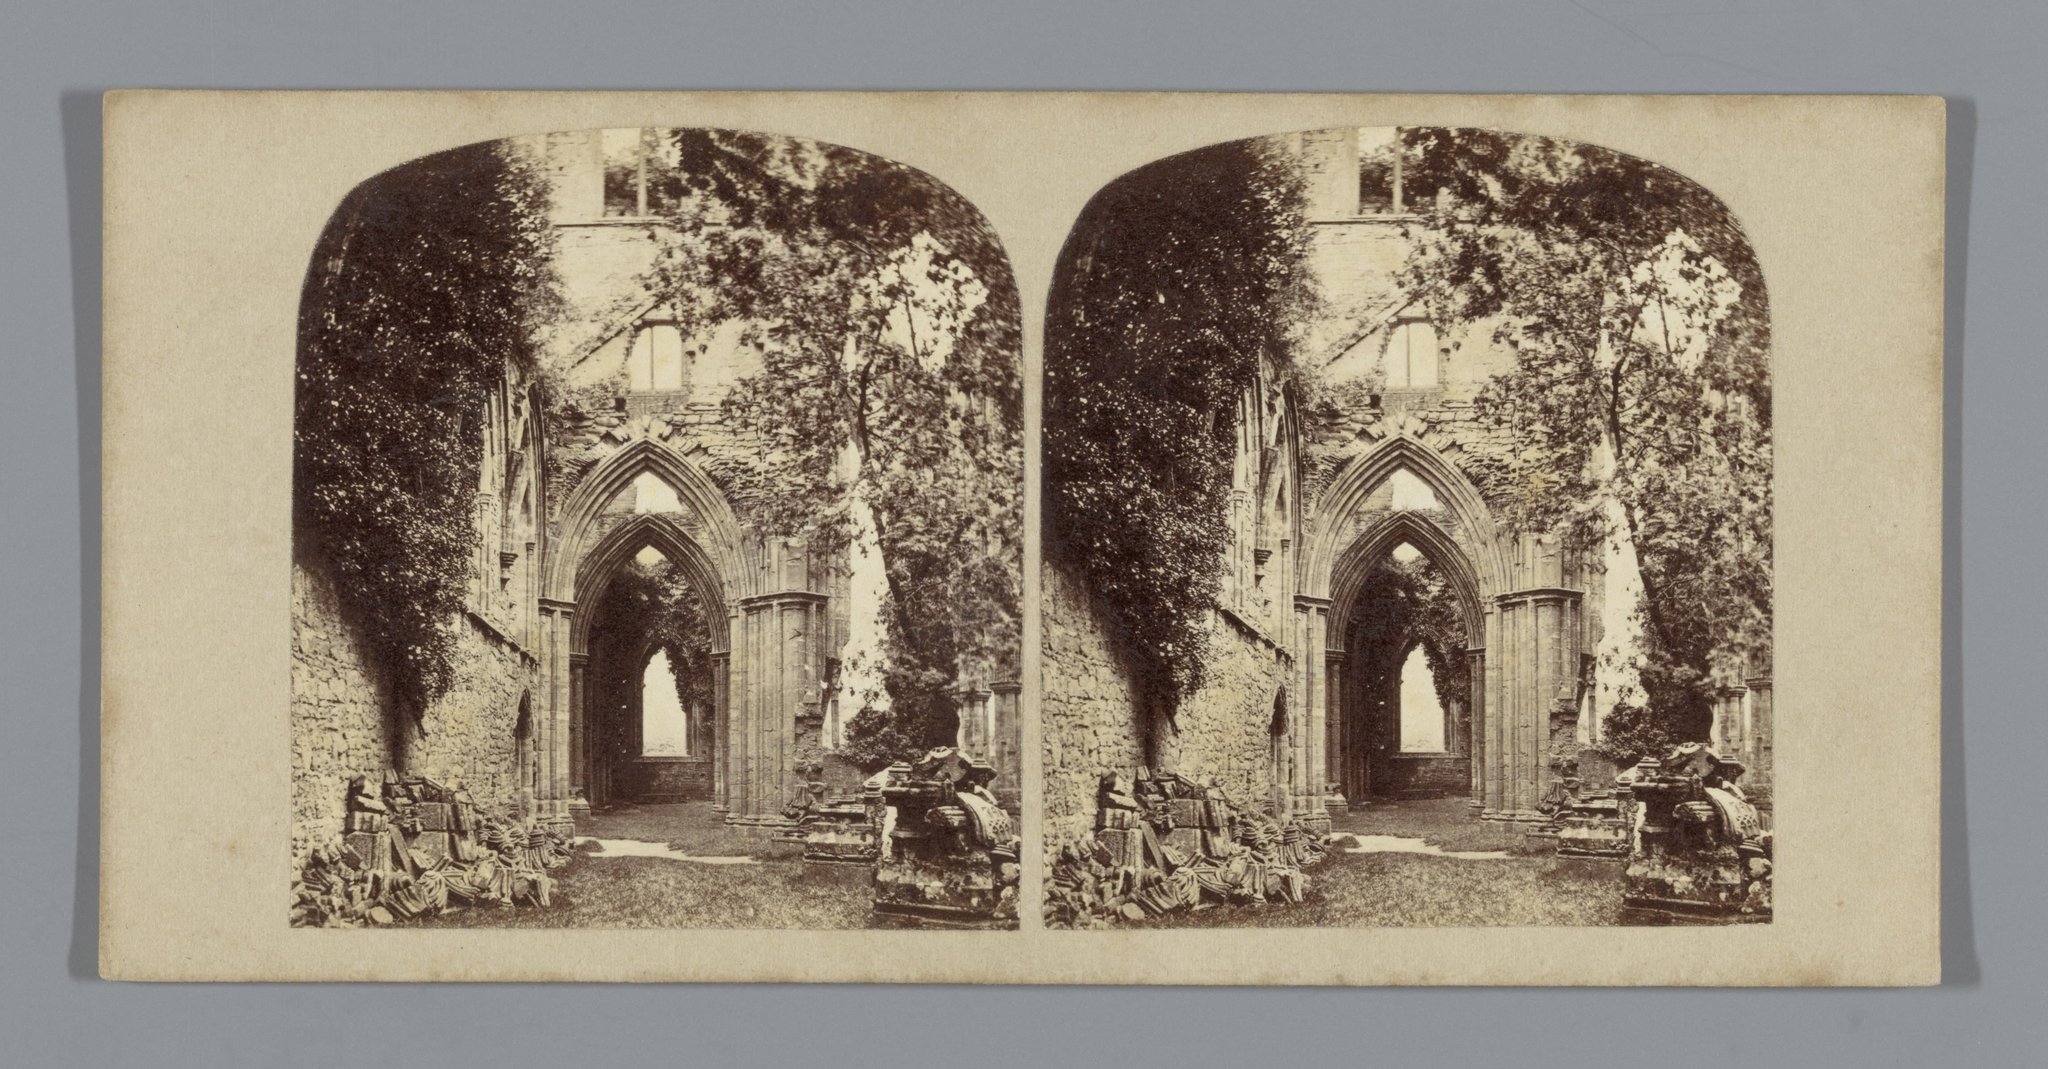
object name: stereograph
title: Ruïne van Tintern Abbey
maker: Anonymous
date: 1850-1880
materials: cardboard, photographic support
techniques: albumen print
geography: tintern abbey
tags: ruin of church, monastery, etc.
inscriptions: number: ‘No. 655 to 639.’